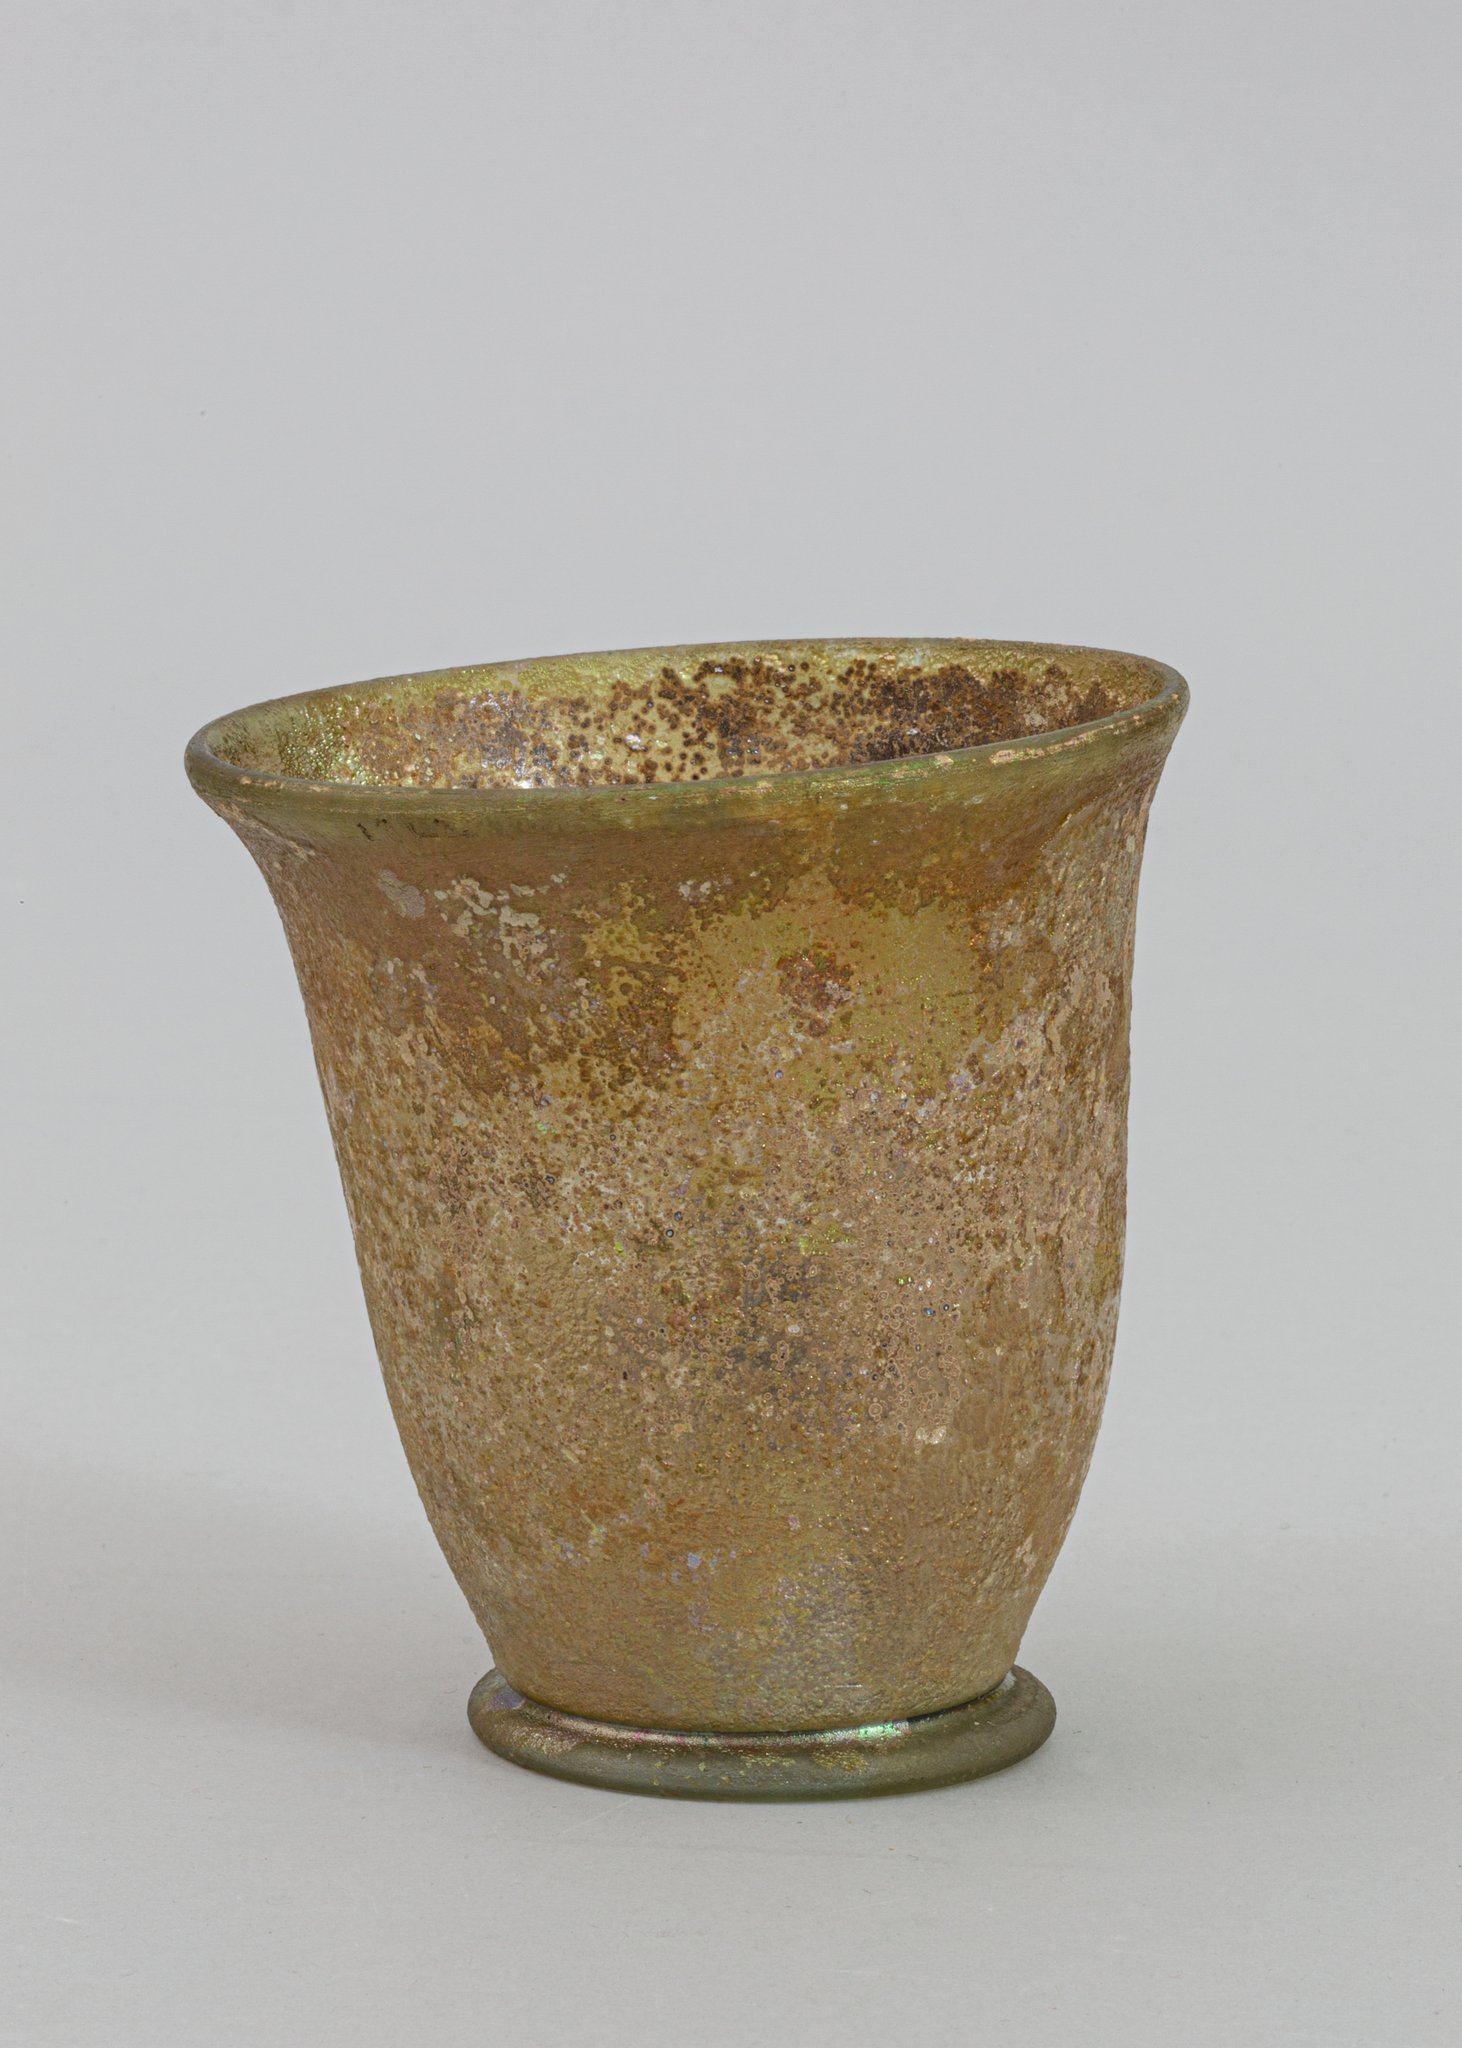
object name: beaker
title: Glass beaker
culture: roman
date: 201-400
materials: glass